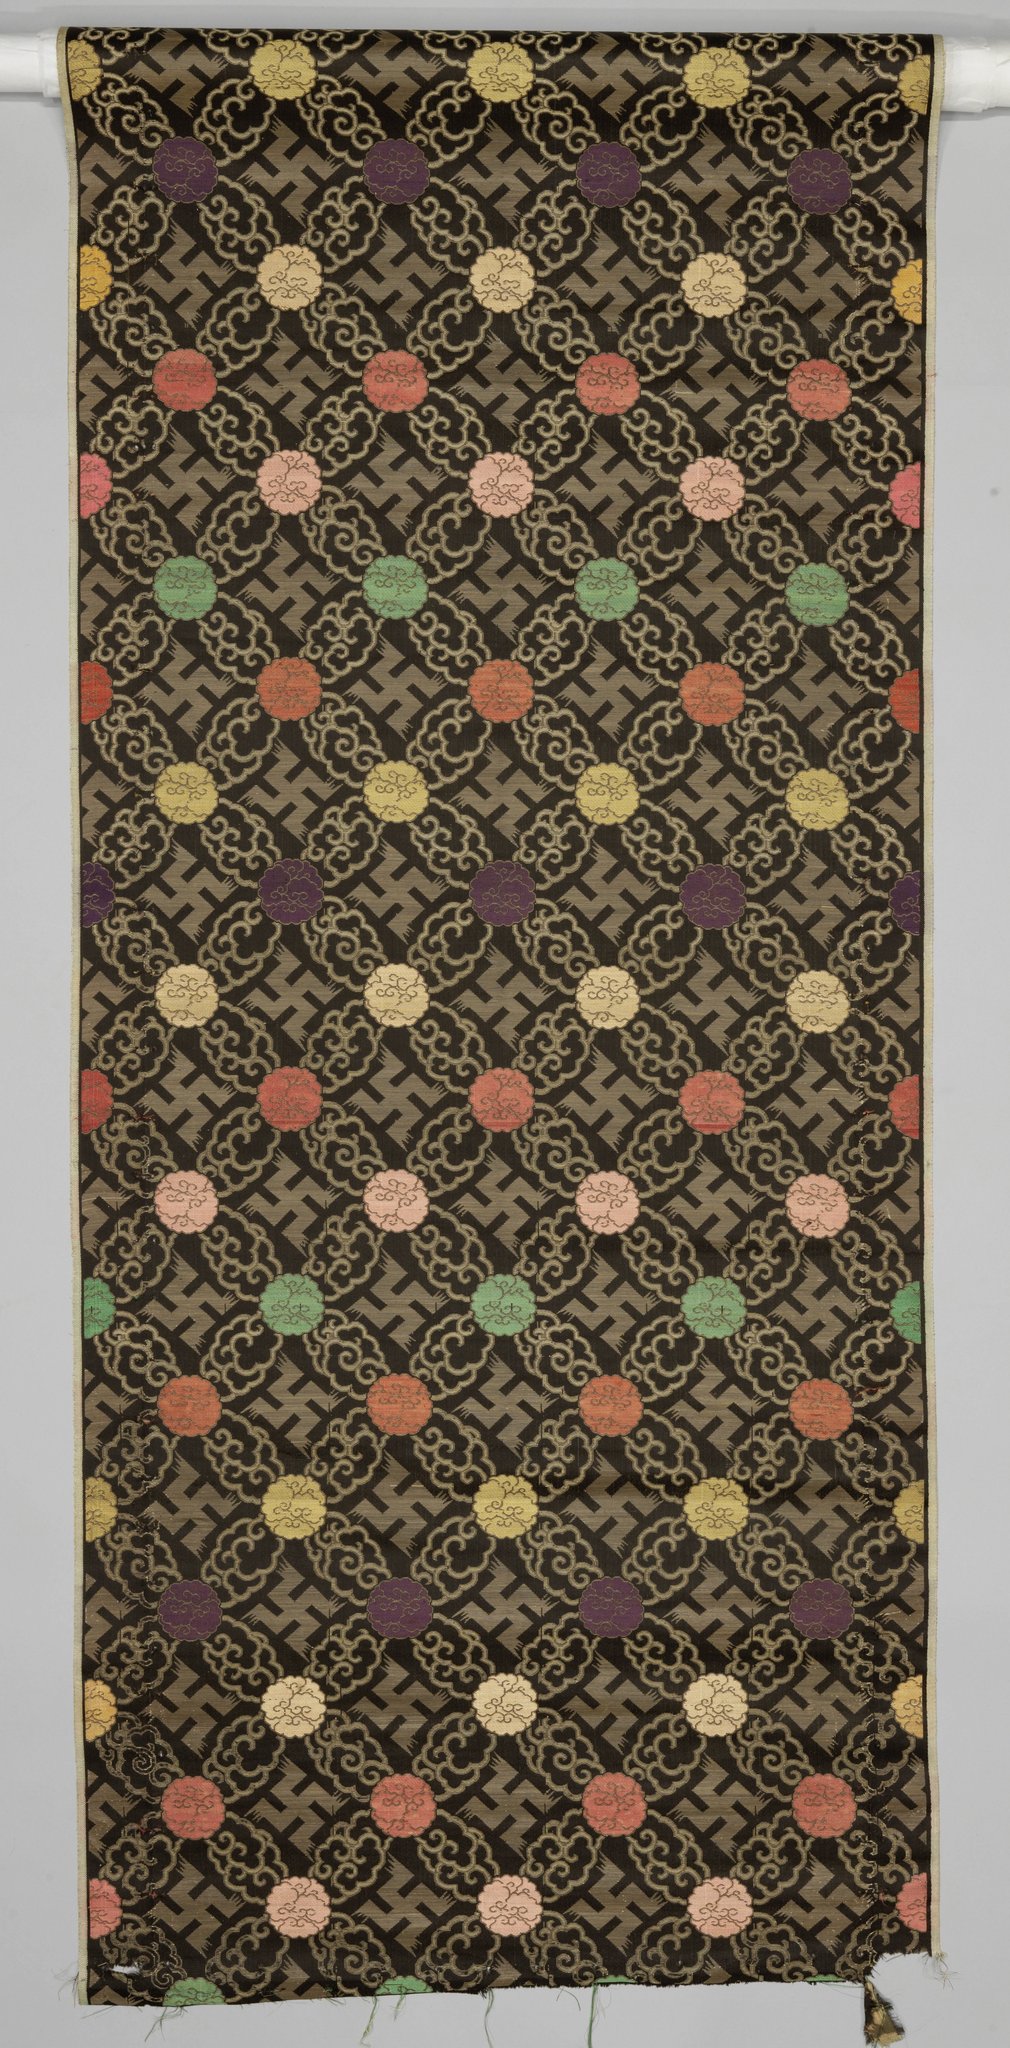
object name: silk textile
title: Baan zijde met een dessin van swastica's gevat in een "ruit" van wolkenbanden met op de kruispunten van de ruit cirkelvormige bloemen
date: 1900-1920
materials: silk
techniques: launching, satin binding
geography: japan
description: Baan zijde met dessin van swastica's gevat in een "ruit" van wolkenbanden in goudbruine tinten, met op de kruispunten van de ruit, cirkelvormige bloemen in roze, beige, rood en paars op een donkerbruine fond. Oosters textiel.